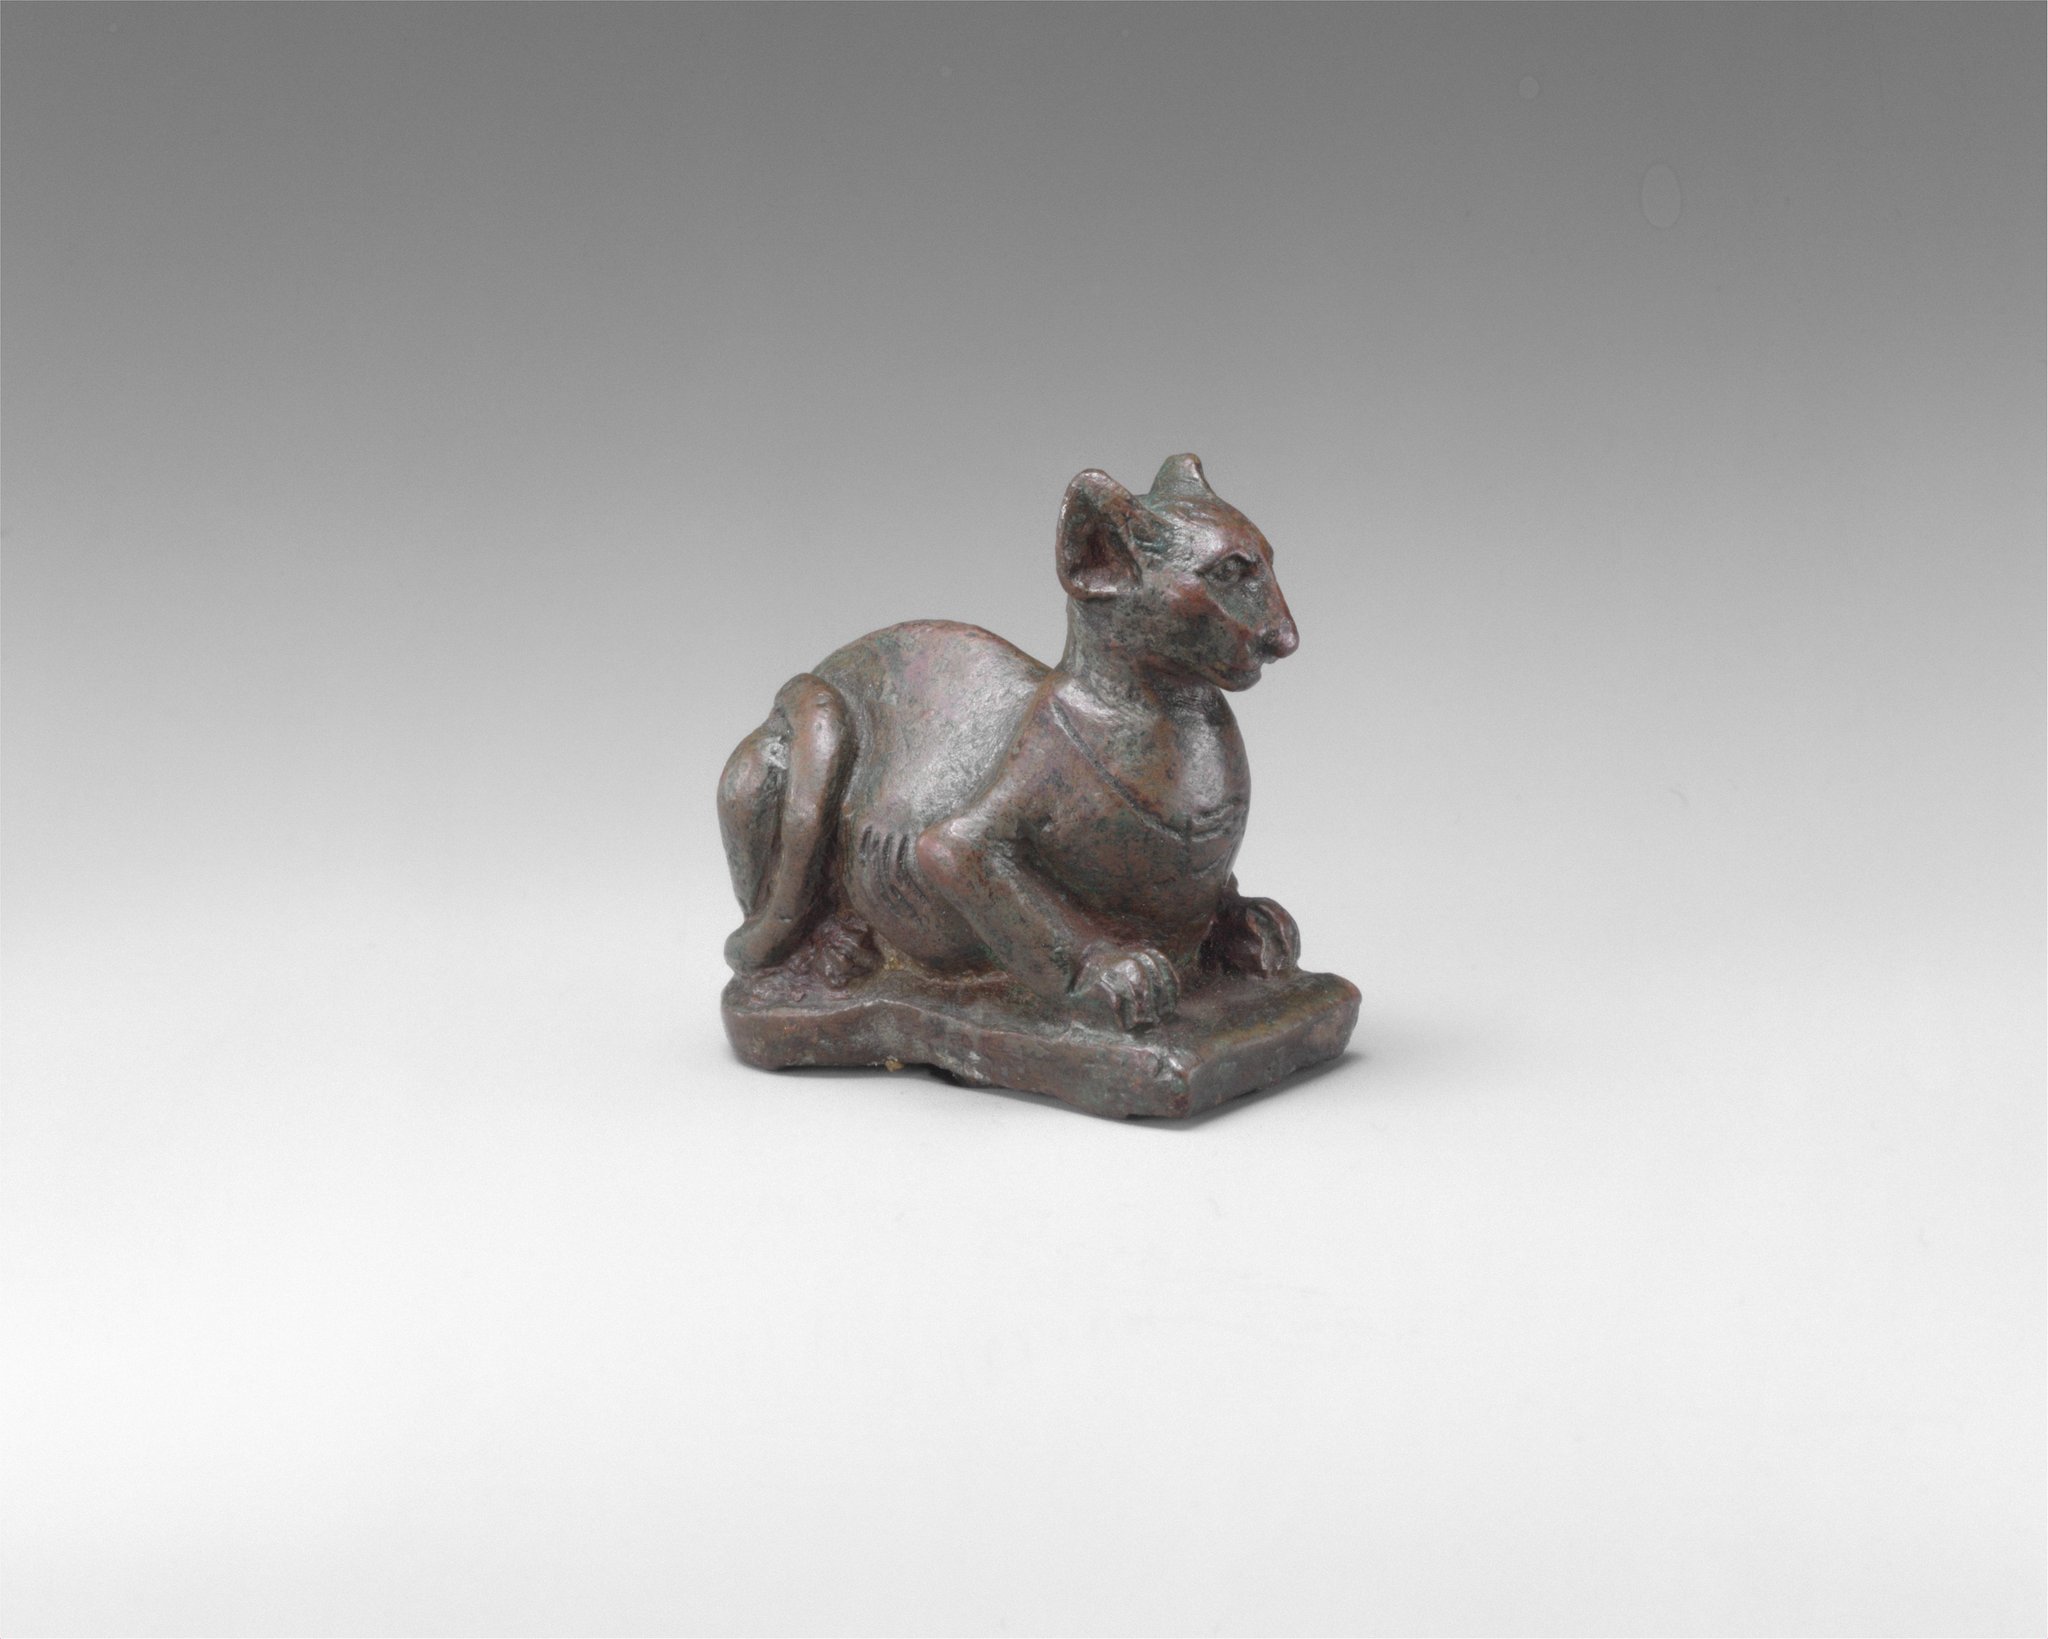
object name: figurine, cat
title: Crouching Cat Figurine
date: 664-380 BCE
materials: bronze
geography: egypt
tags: cats